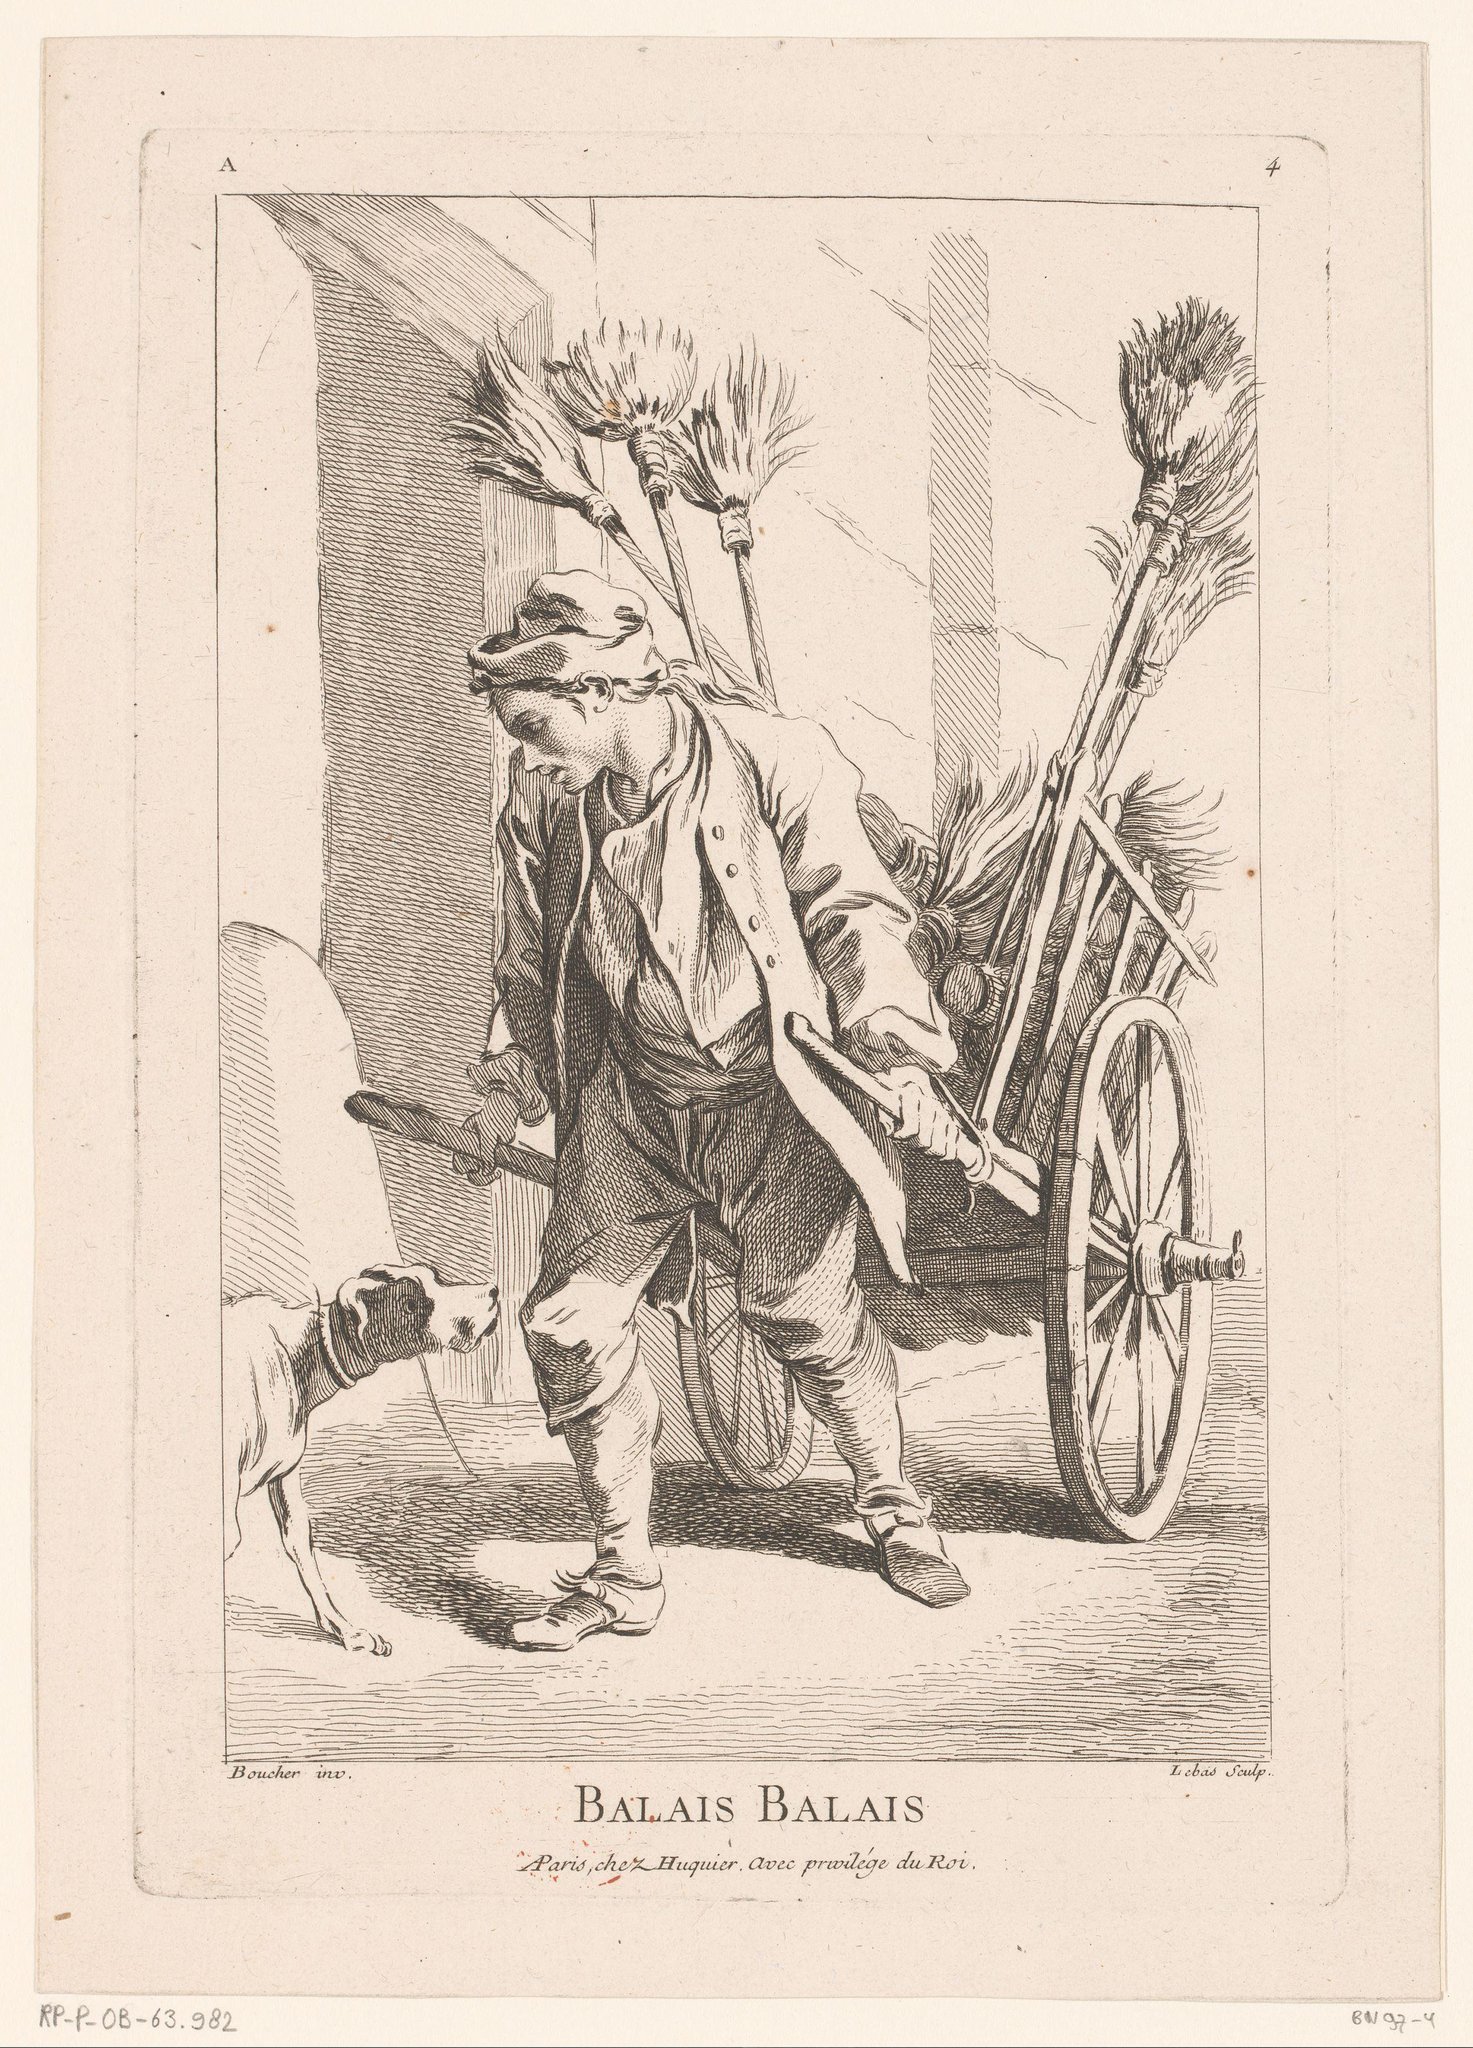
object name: print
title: Cris de Paris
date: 1736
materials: paper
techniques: etching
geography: paris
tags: street-trader, 'cris de paris', cries of london, etc.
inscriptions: collector's mark: Lugt 240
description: Maakt deel uit van een twaalfdelige serie met straatverkopers naar ontwerp van Boucher en in prent gebracht door Le Bas en Ravenet.